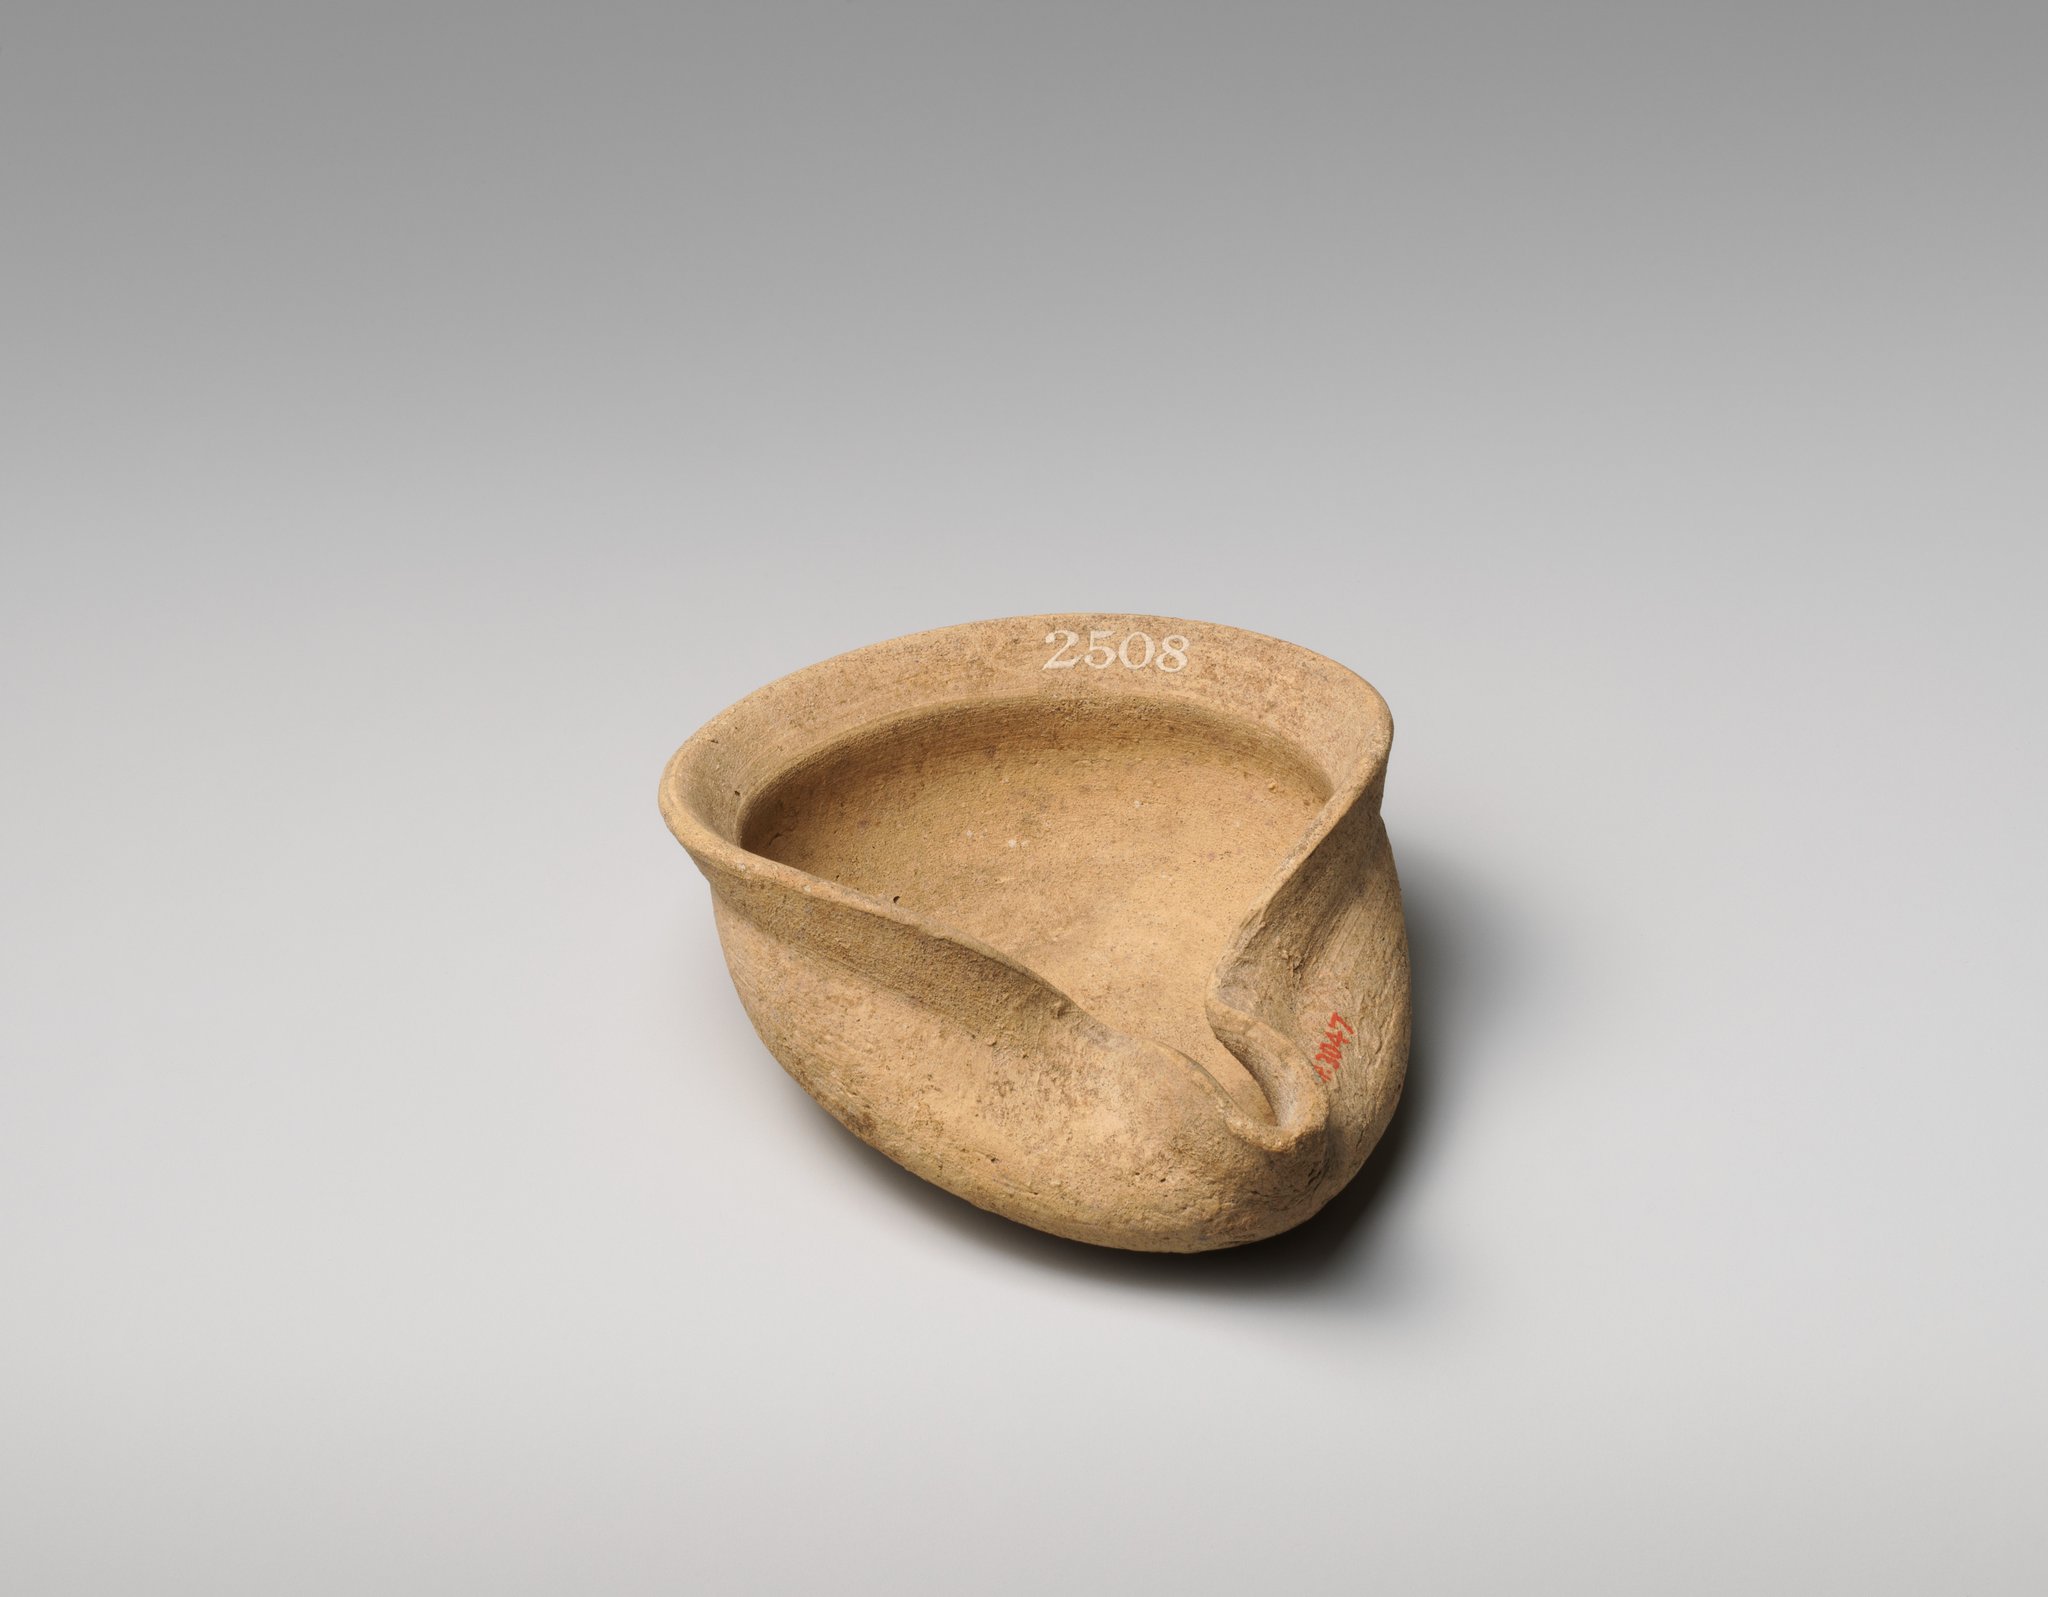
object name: lamp, saucer shaped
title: Terracotta saucer-shaped lamp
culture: cypriot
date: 400-301 BCE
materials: terracotta